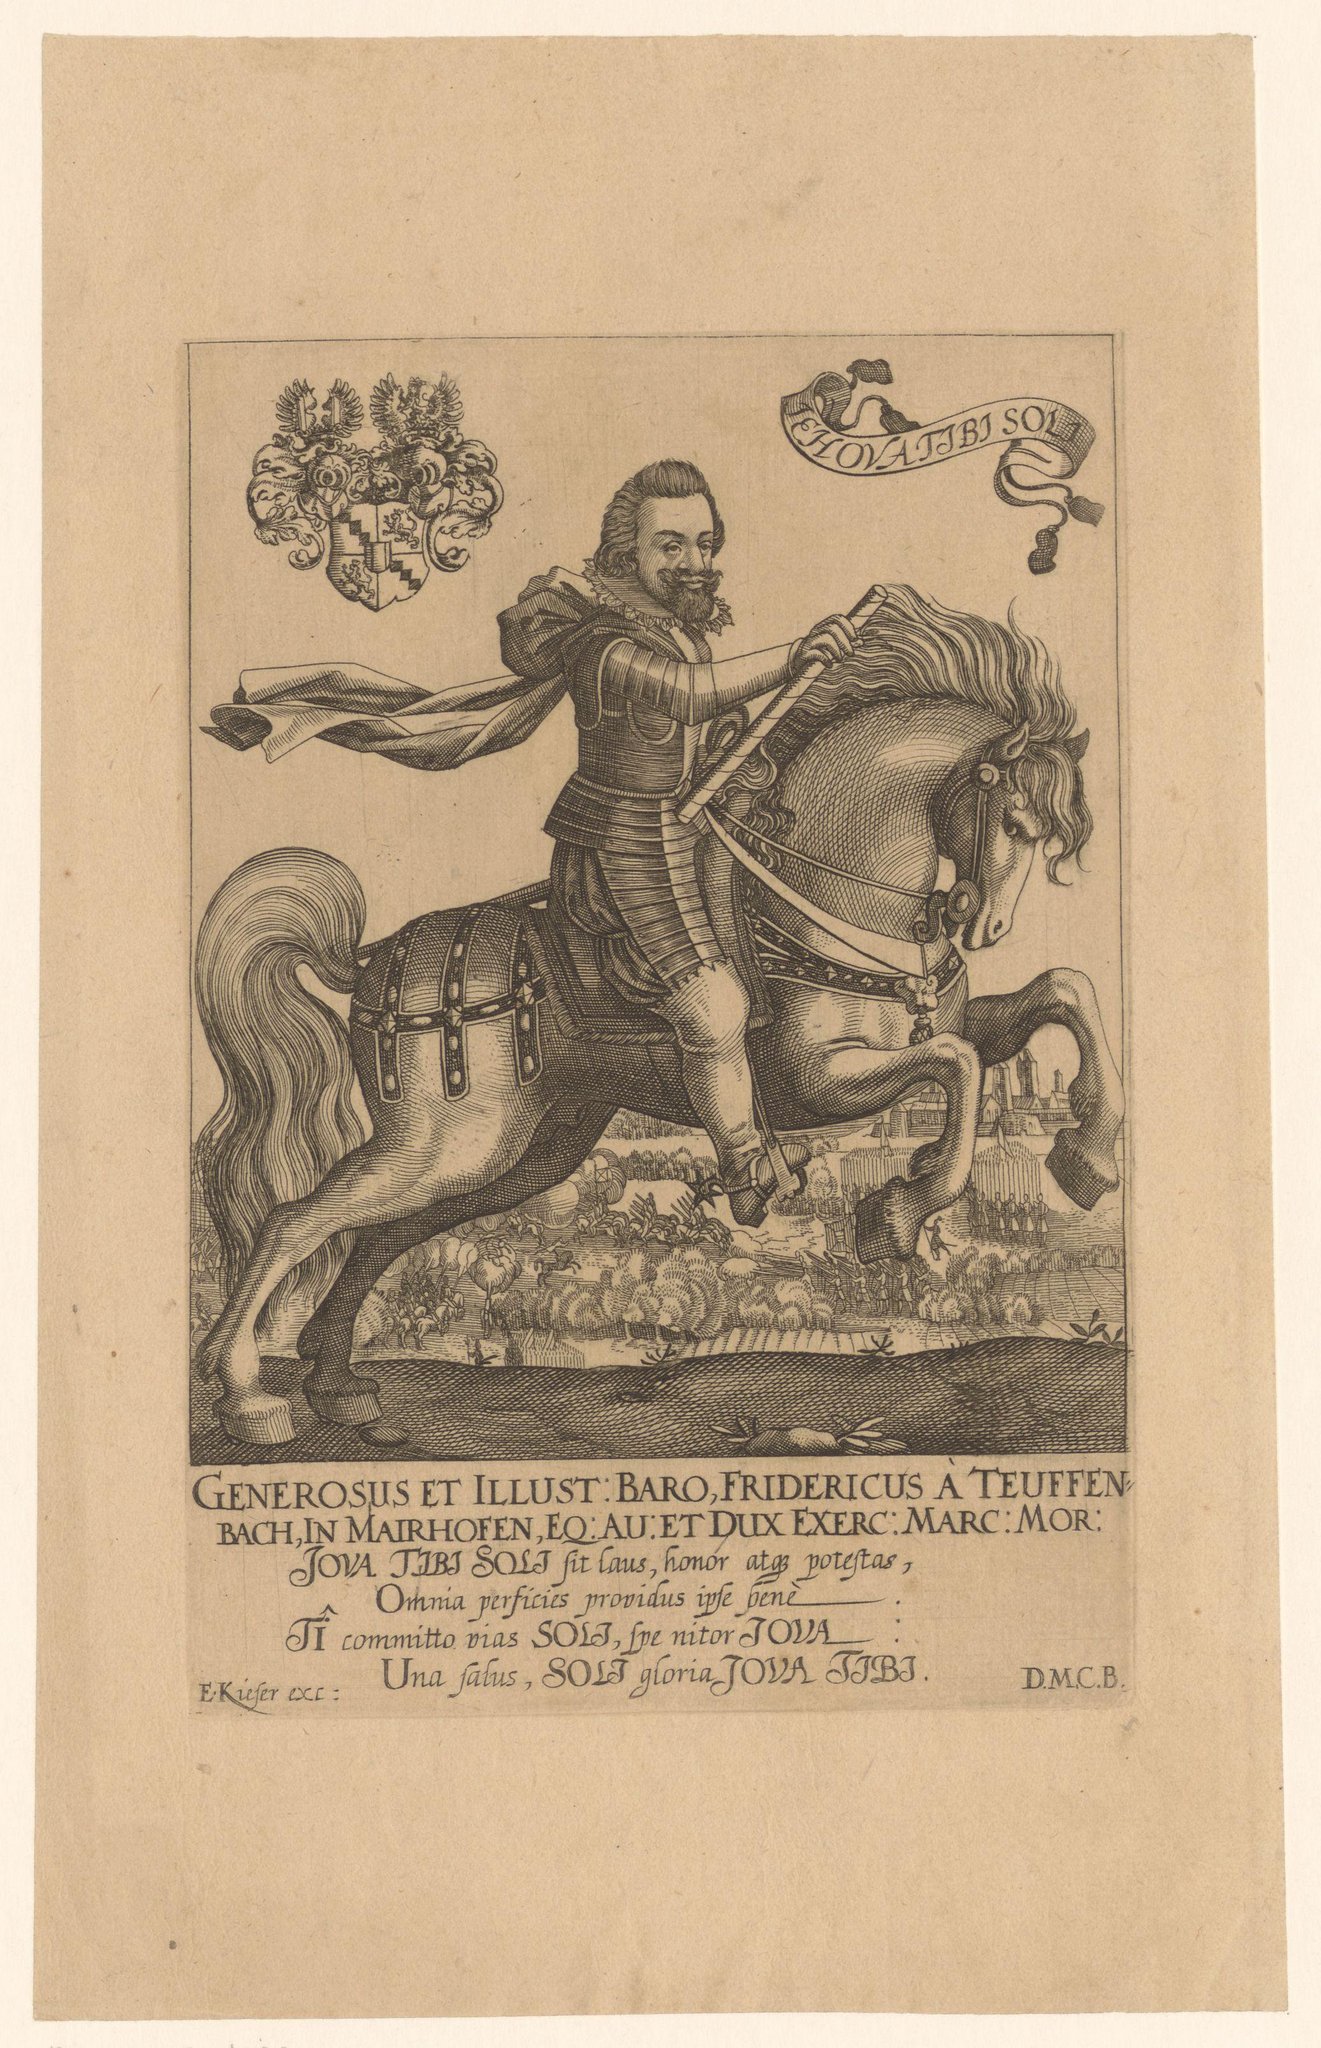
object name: print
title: Portret van Friedrich von Teuffenbach te paard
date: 1593-1625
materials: paper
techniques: engraving, etching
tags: historical persons, officer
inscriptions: collector's mark: Lugt 2228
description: Daniel Meisner's signatuur eindigt met zijn geboortestad Chomutov (Komotau) in Bohemen, en wordt vaak genoteerd als D.M.C.B.